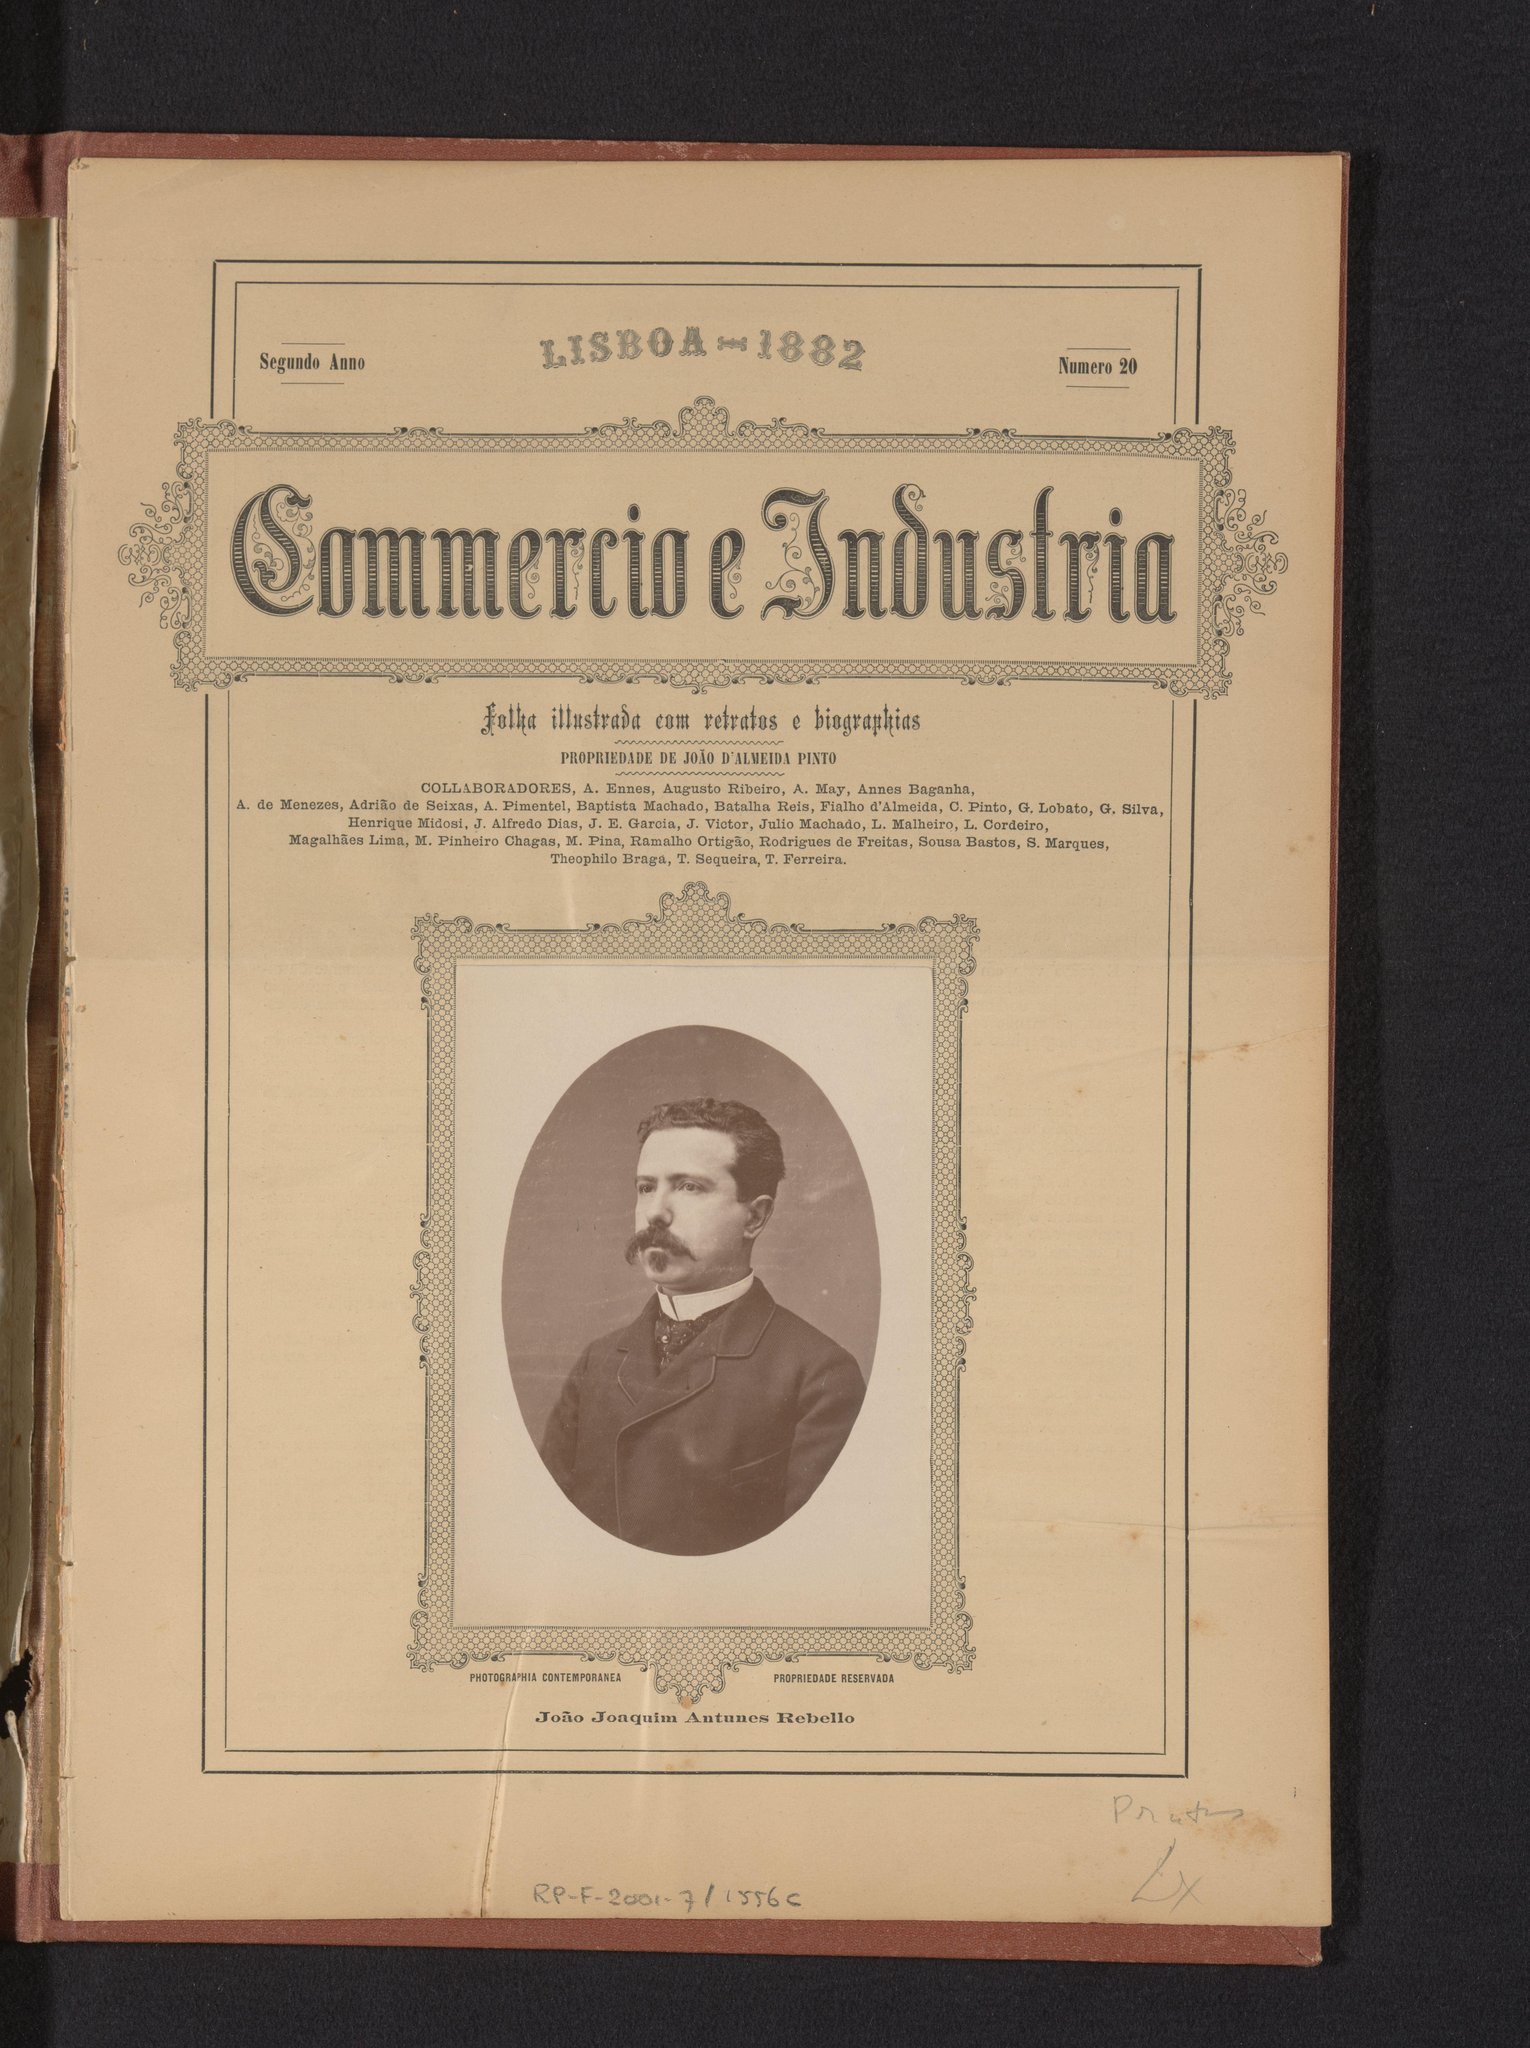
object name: magazine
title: Commercio e industria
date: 1882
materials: paper, photographic support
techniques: albumen print, printing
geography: lisbon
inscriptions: annotation: ‘Pr[...]/ Lx.’